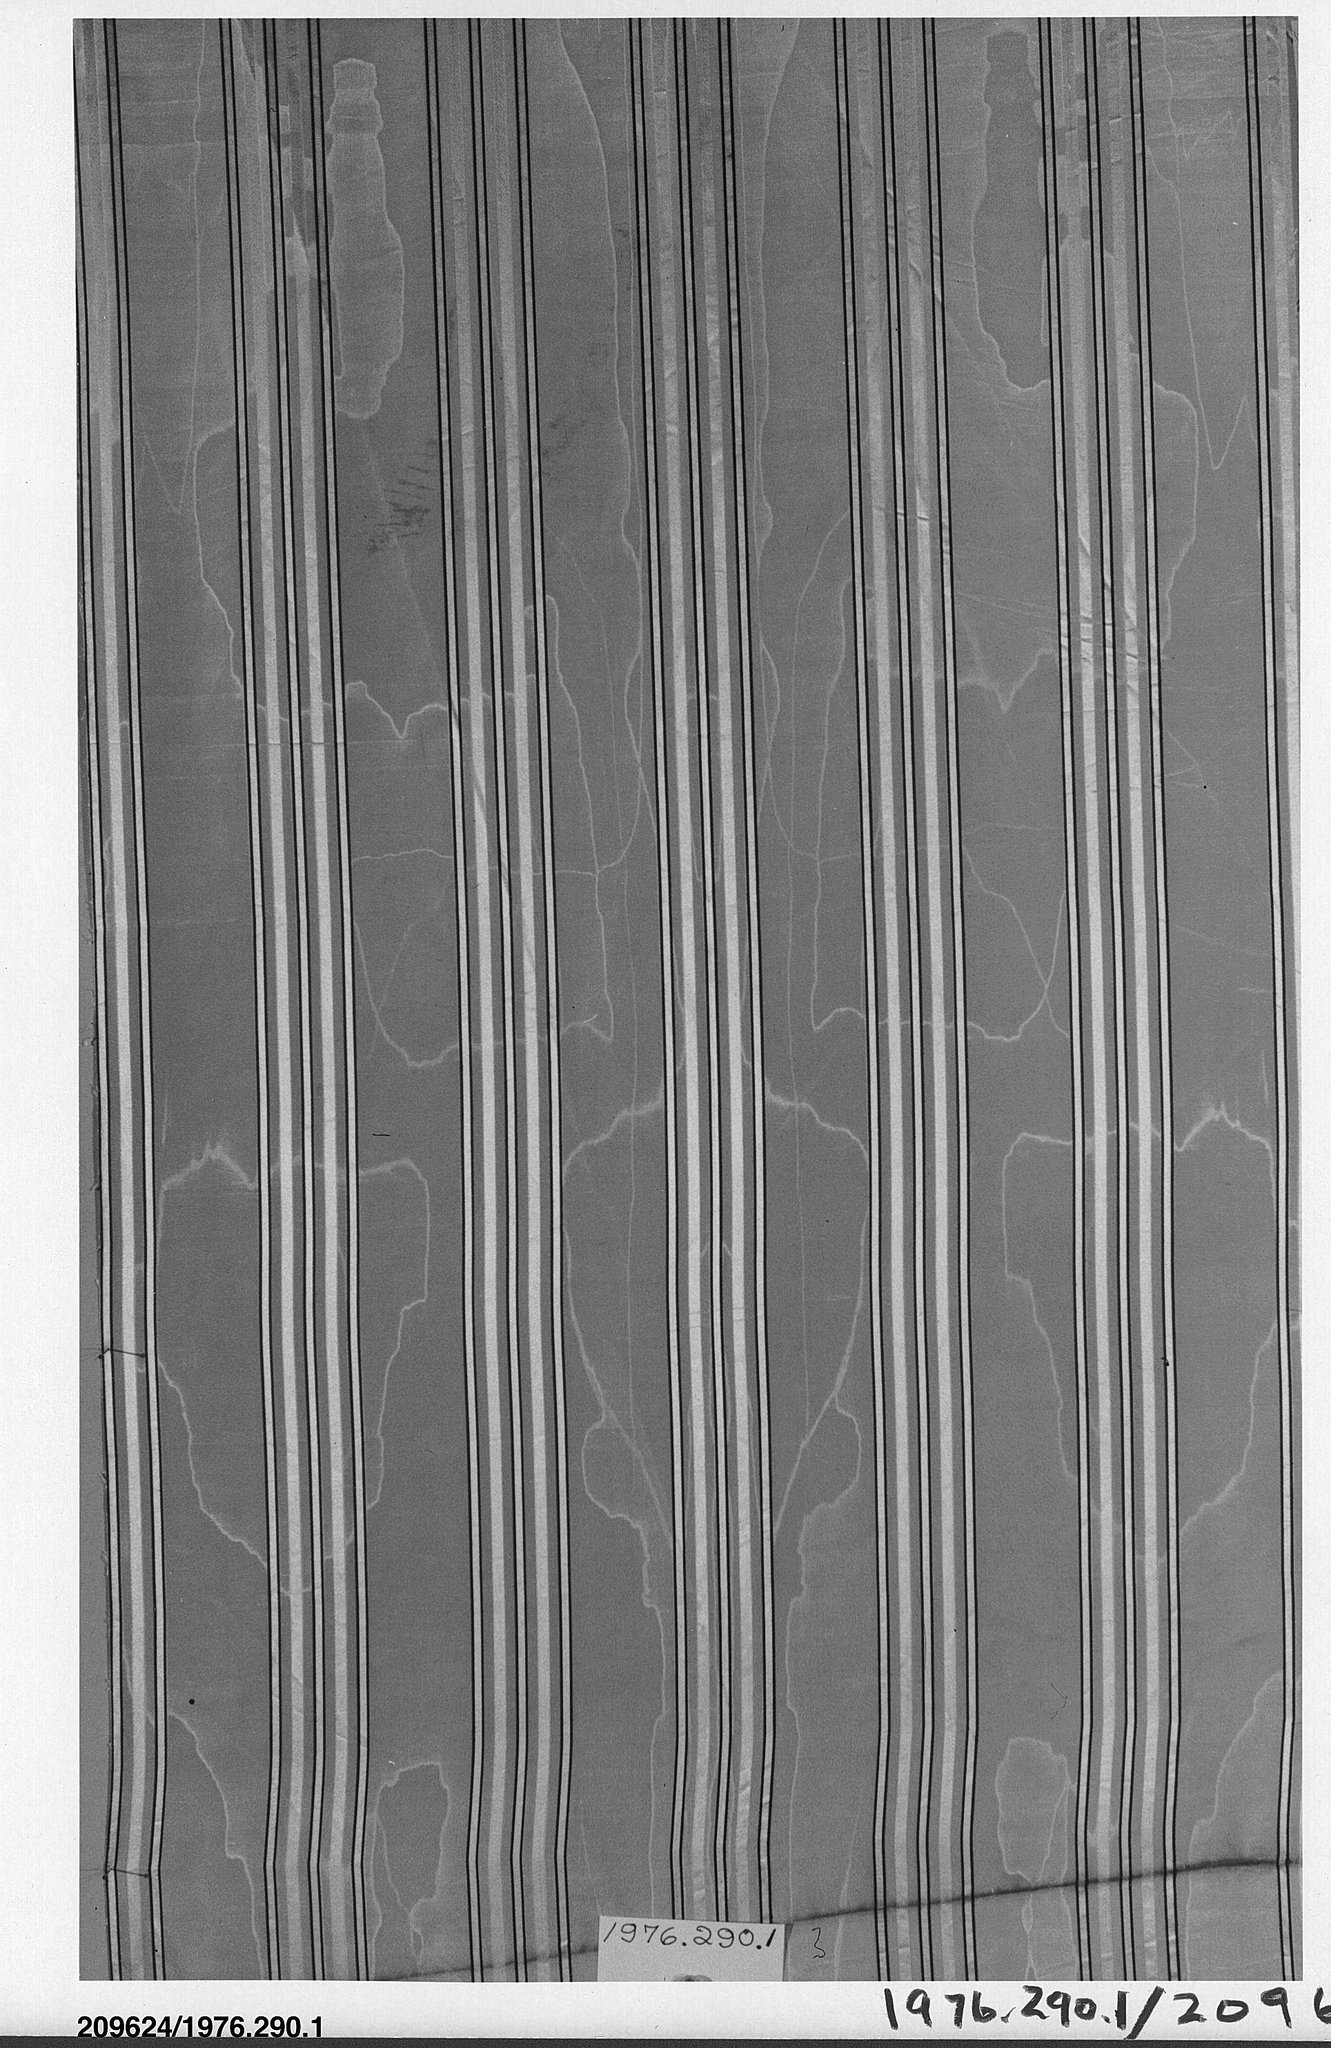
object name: skirt panel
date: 1890-1899